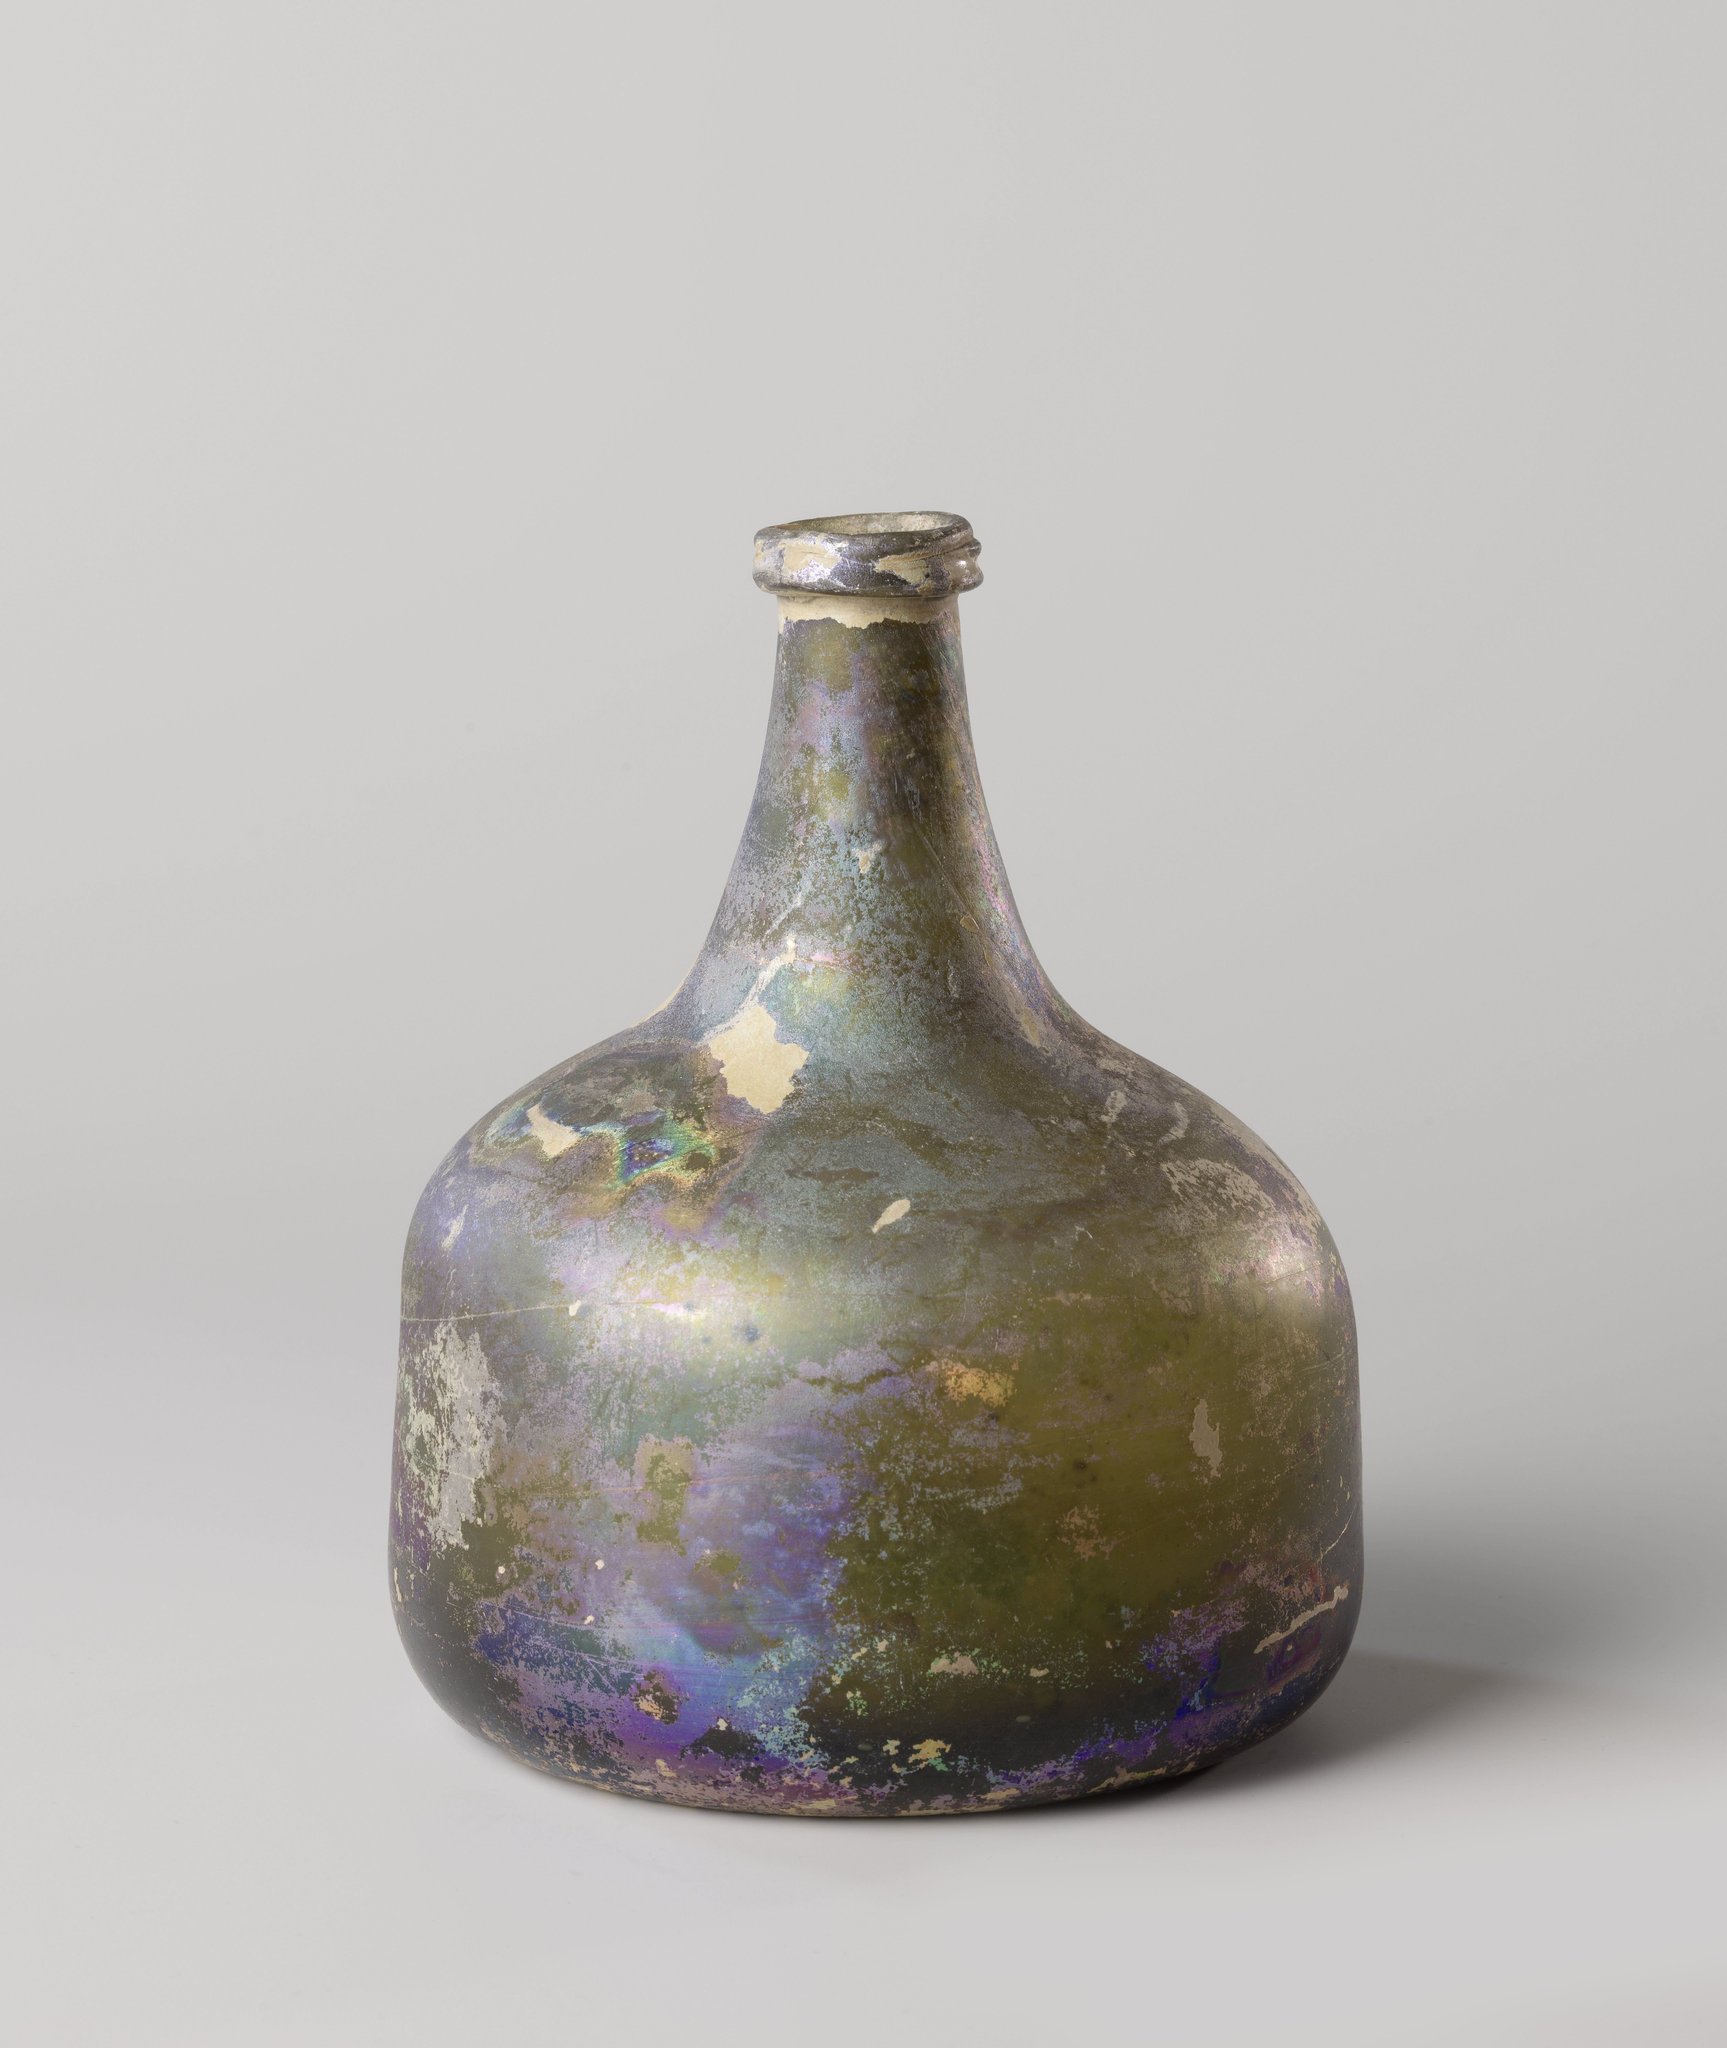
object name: bottle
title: Fles met bolvormig lichaam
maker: Anonymous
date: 1725-1750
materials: glass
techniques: glassblowing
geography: northwest europe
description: Fles, cilindervormig, van donkergroen glas met diepe ziel, wordt naar boven toe smaller naar ronde schouder waarboven hals met ring langs de rand